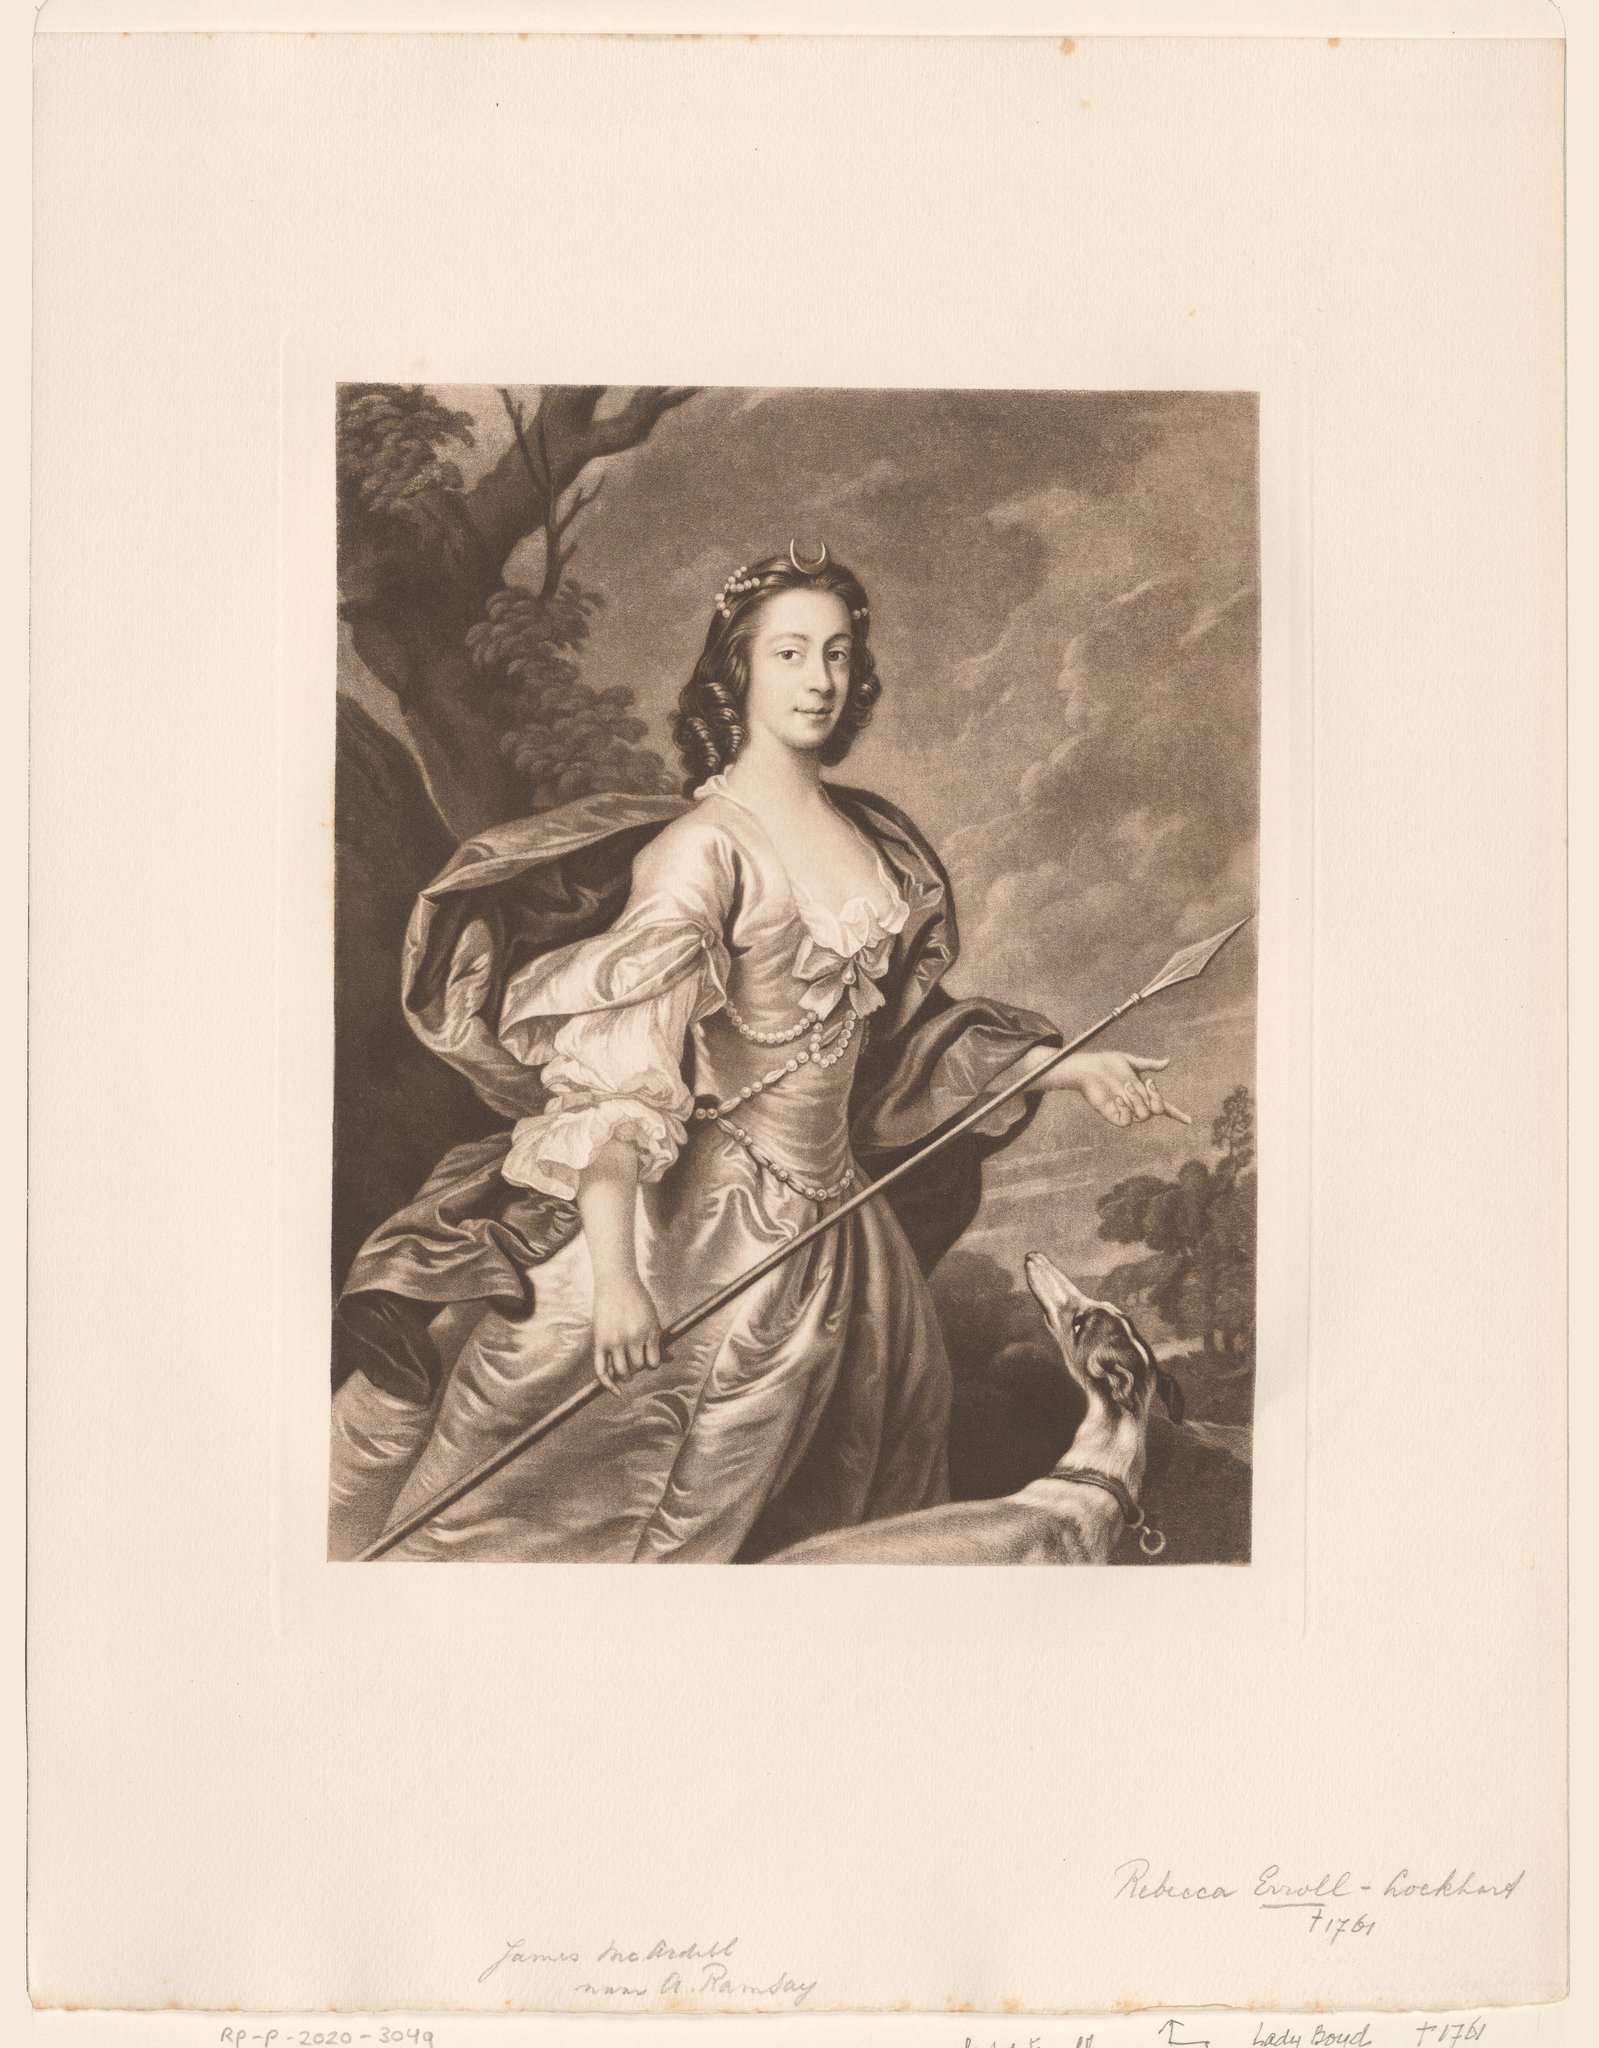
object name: photomechanical print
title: Portret van Rebecca Lockhart als Diana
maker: Anonymous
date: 1870-1915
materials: paper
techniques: photoaquatint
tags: (story of) diana (artemis), historical persons - bb - woman